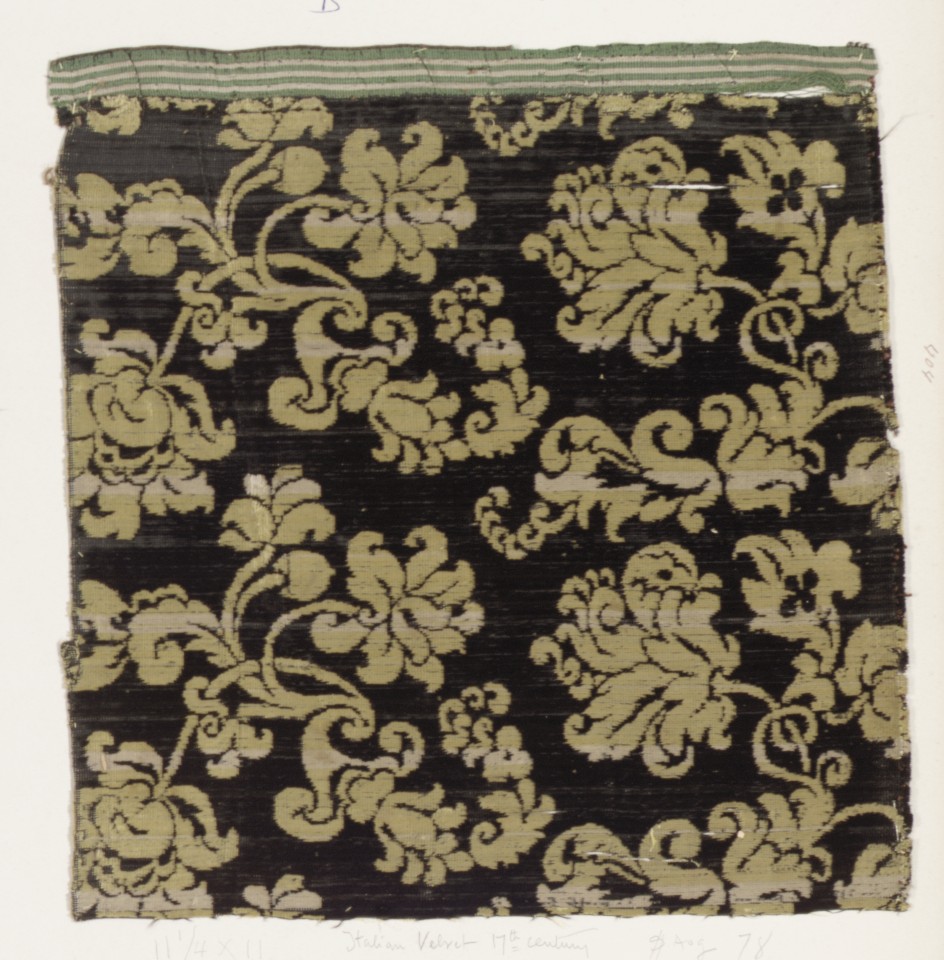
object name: fragment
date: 1601-1700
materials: silk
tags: flowers,leaves